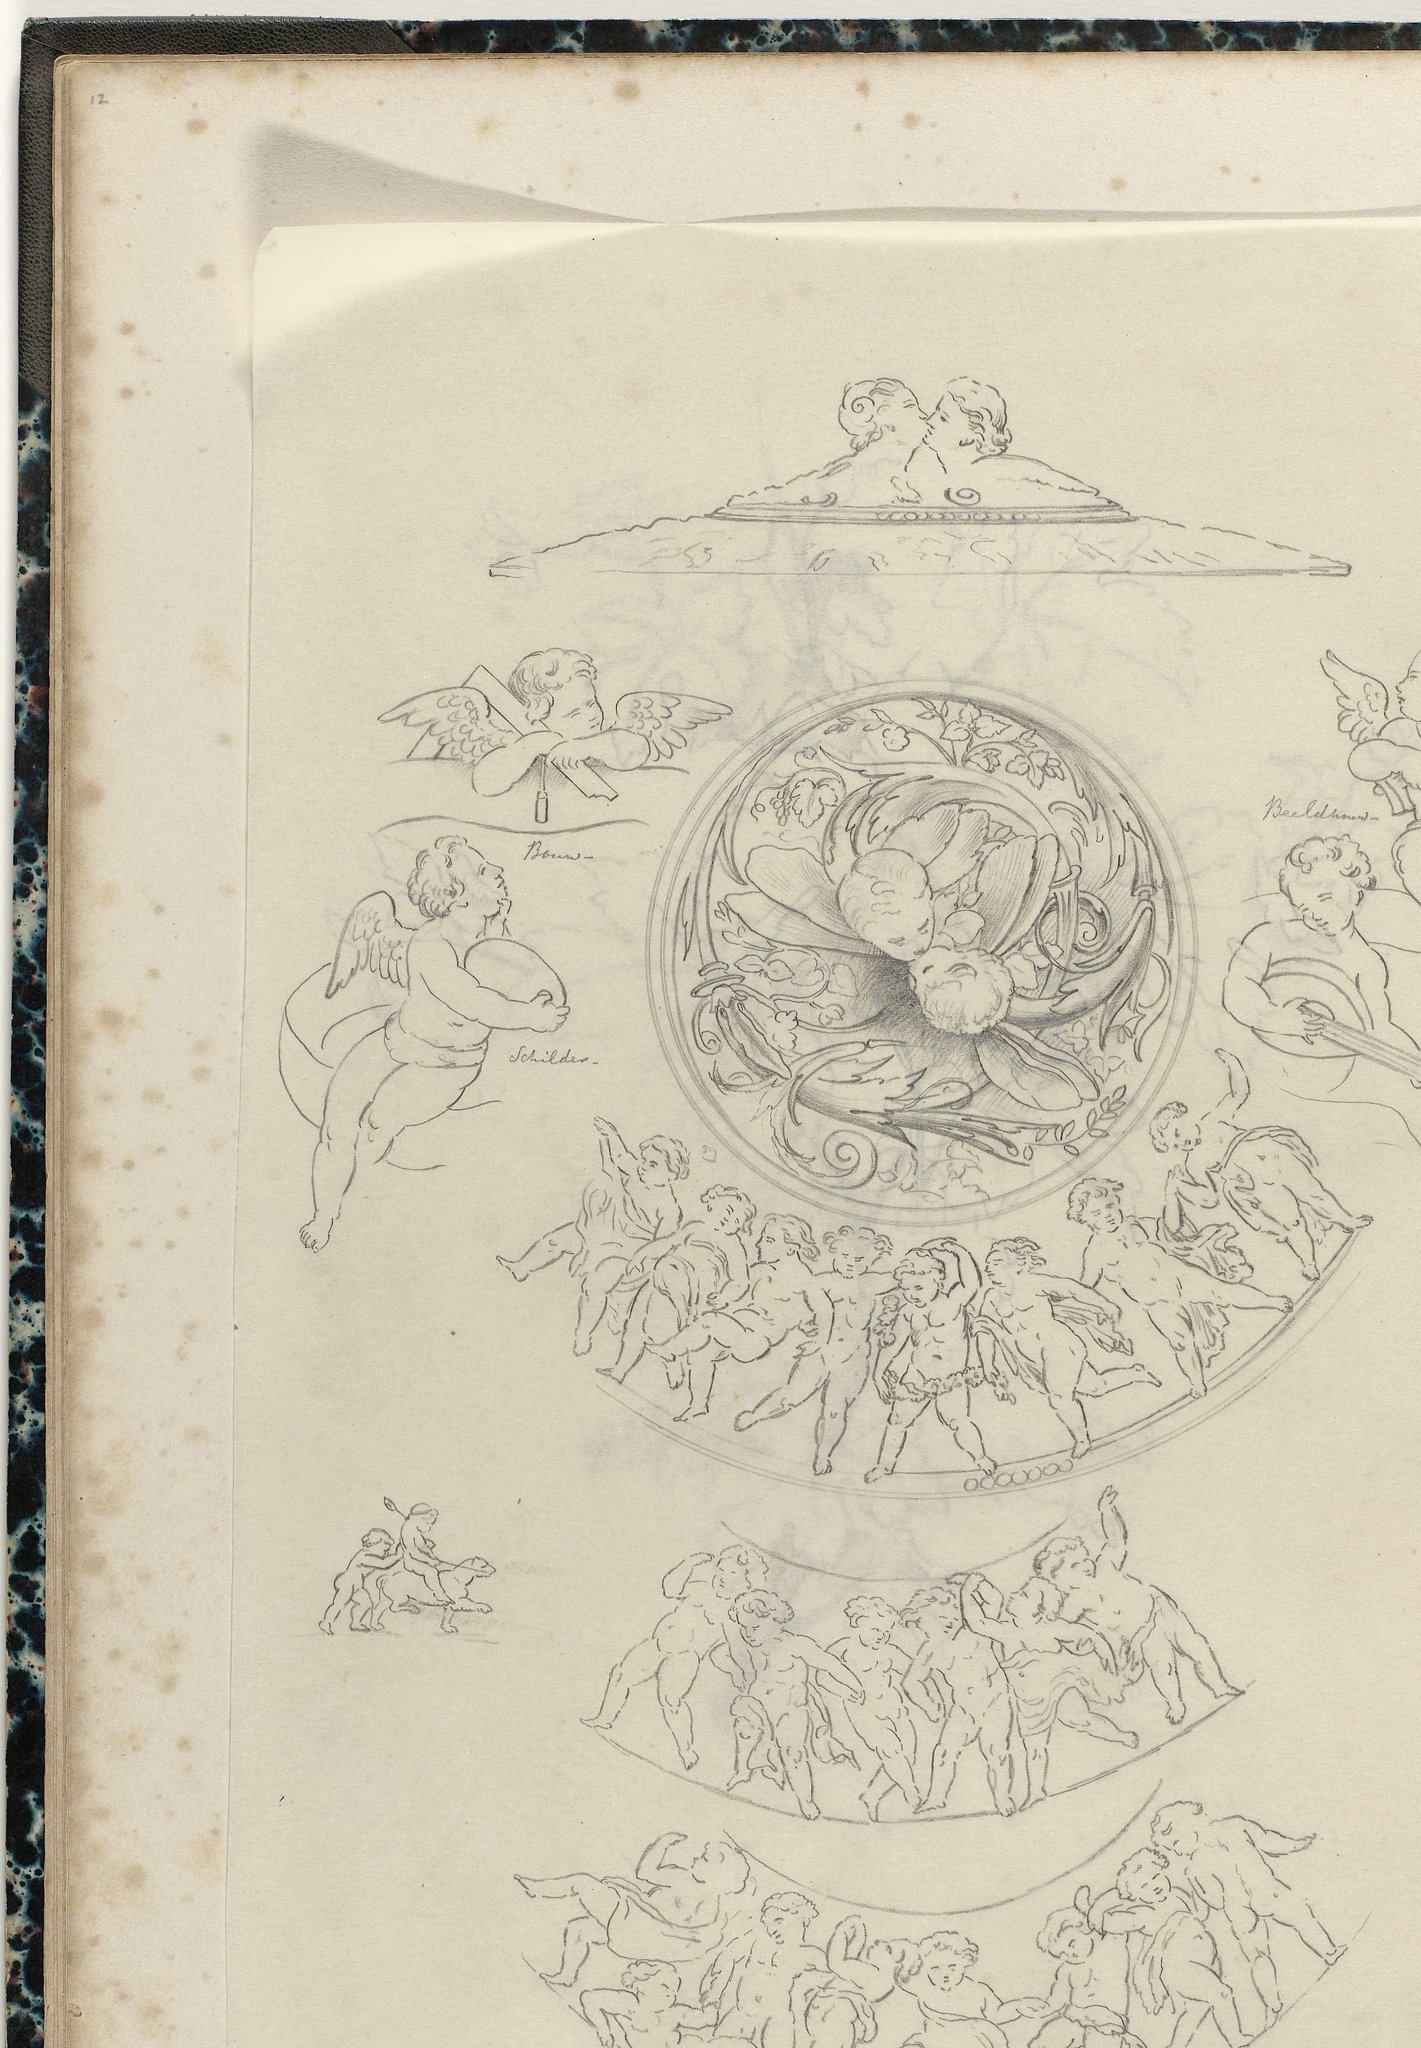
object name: drawing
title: Tien ornamenten met putti en cherubijnen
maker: Anonymous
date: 1866-1900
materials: pencil, paper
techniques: drawing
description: In het midden van het blad is een cirkel getekend met daarin twee gevleugelde figuren die ontspruiten uit een bladrank. Rondom de cirkel bevinden zich vier cherubijnen waarbij met potlood geschreven staat: Bouw-, Schilder-, Beeldhouw- en Toonkunst.